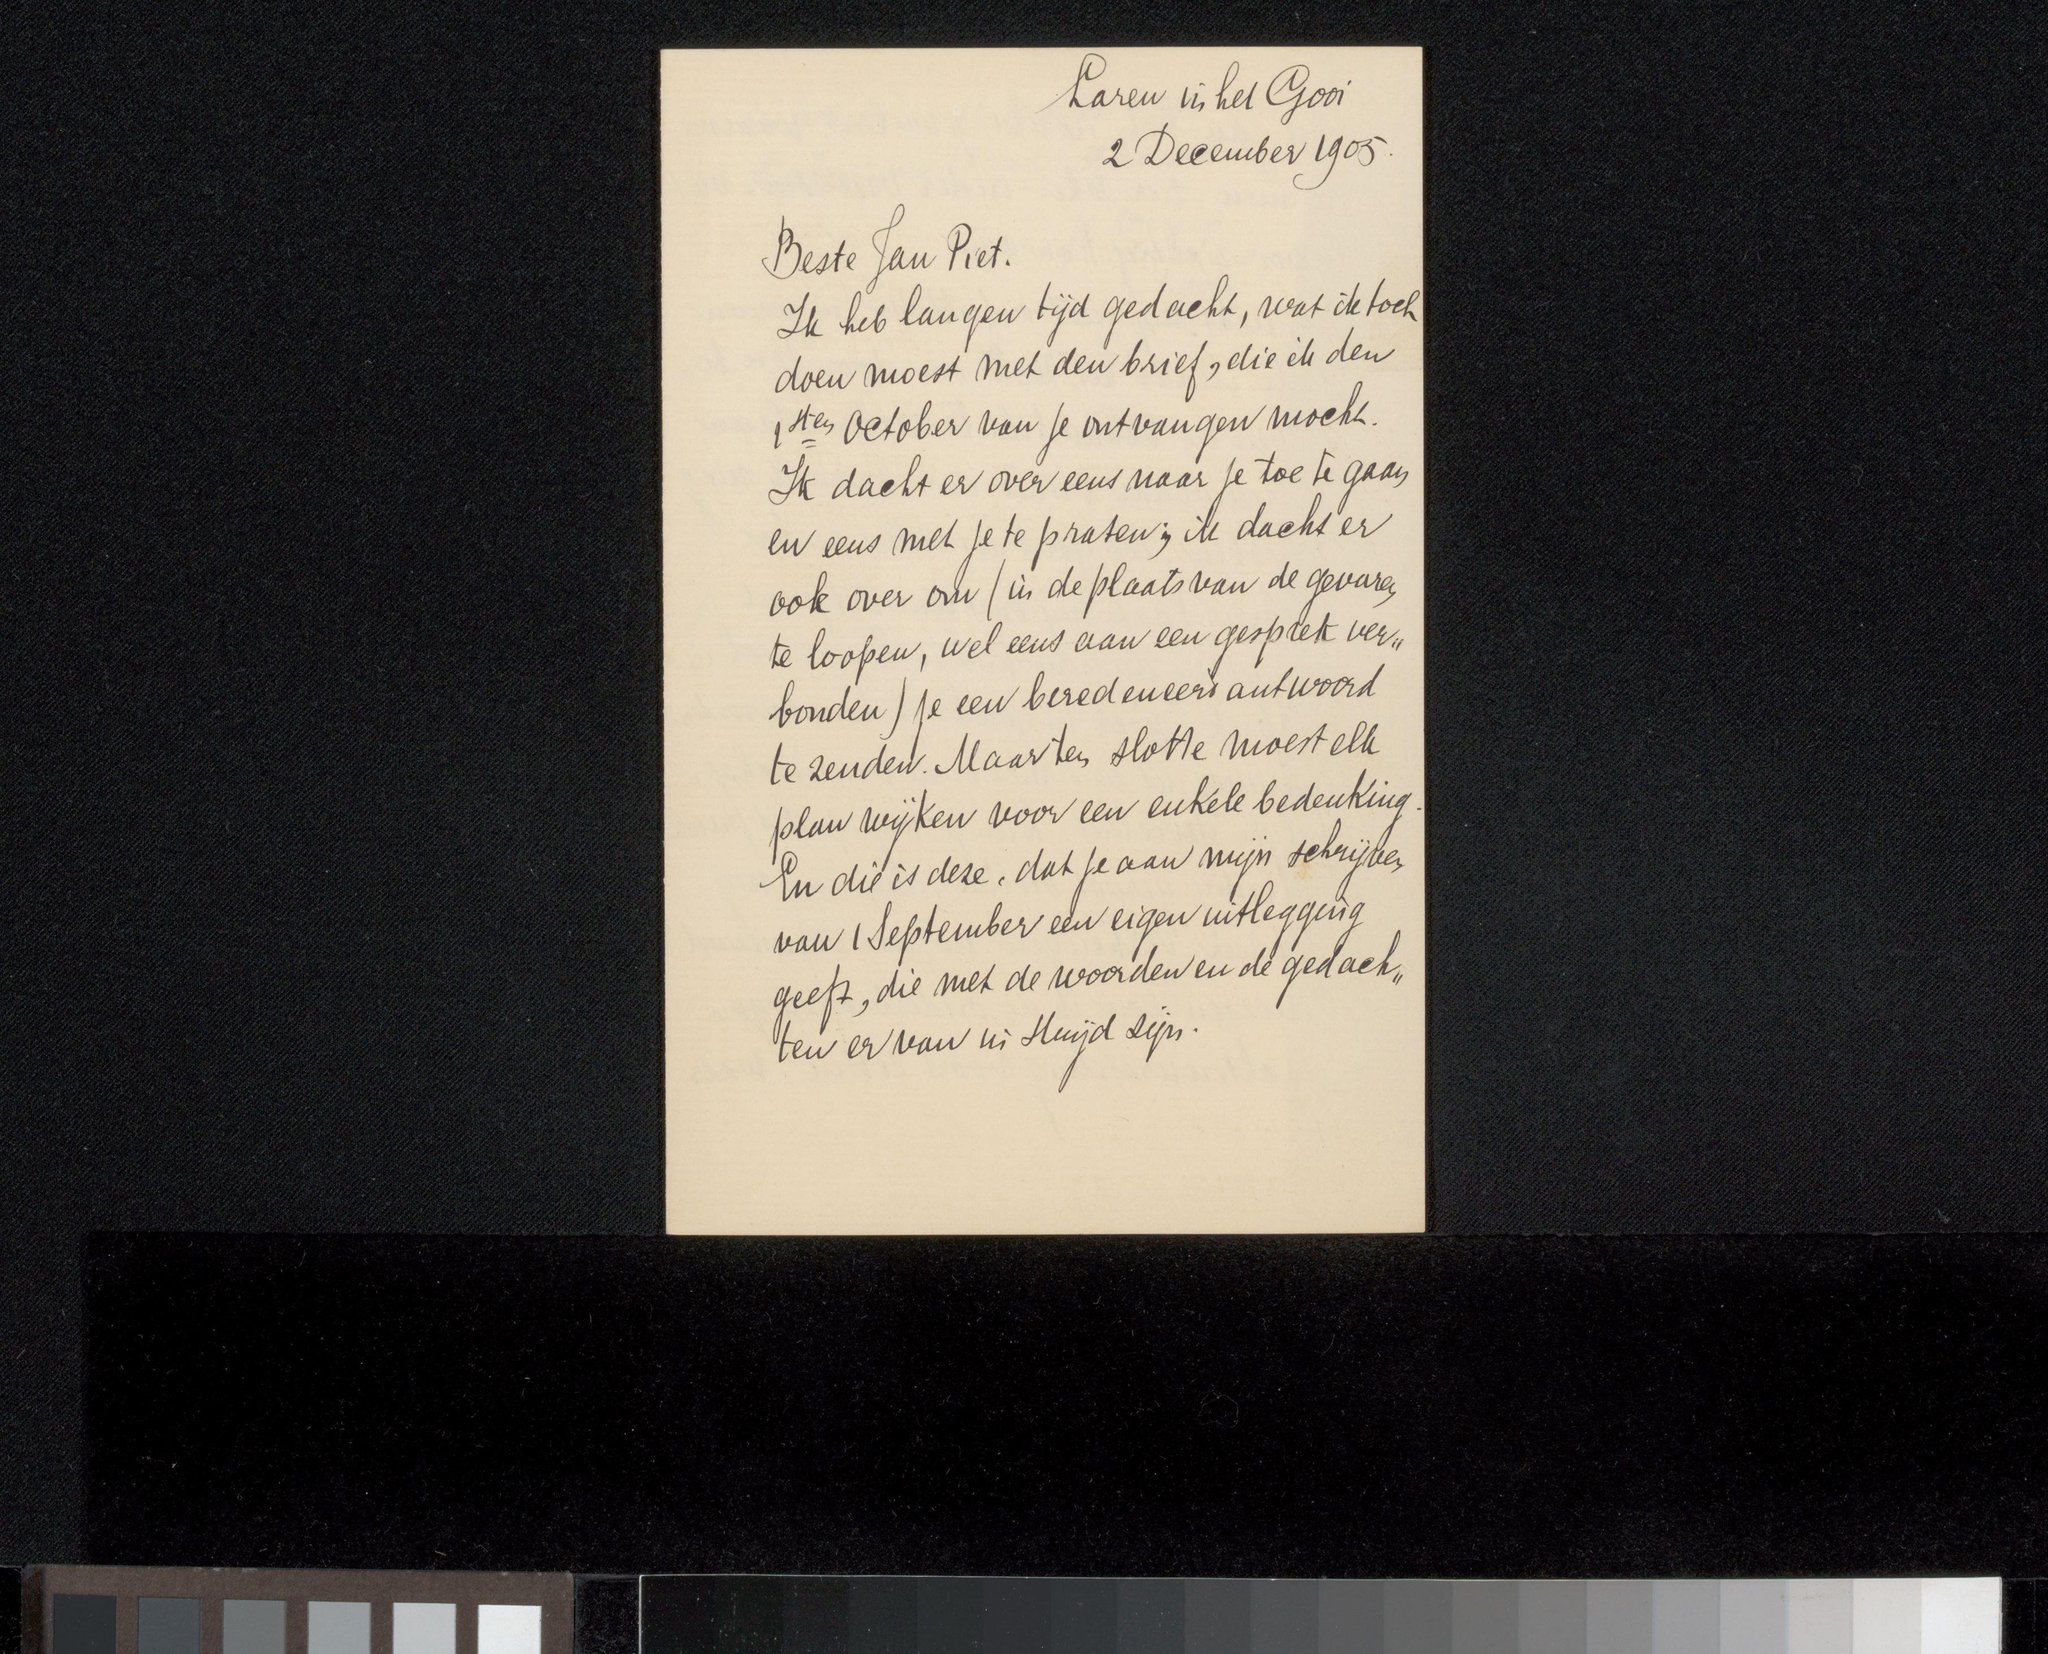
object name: letter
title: Brief aan Jan Veth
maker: antoon derkinderen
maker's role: draughtsman, painter, print maker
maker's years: 1859-1925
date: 1905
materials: ink, paper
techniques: pen, writing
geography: laren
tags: dordrecht, amsterdam, painter, print maker, draughtsman, designer, jan veth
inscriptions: collector's mark: ‘RPK’